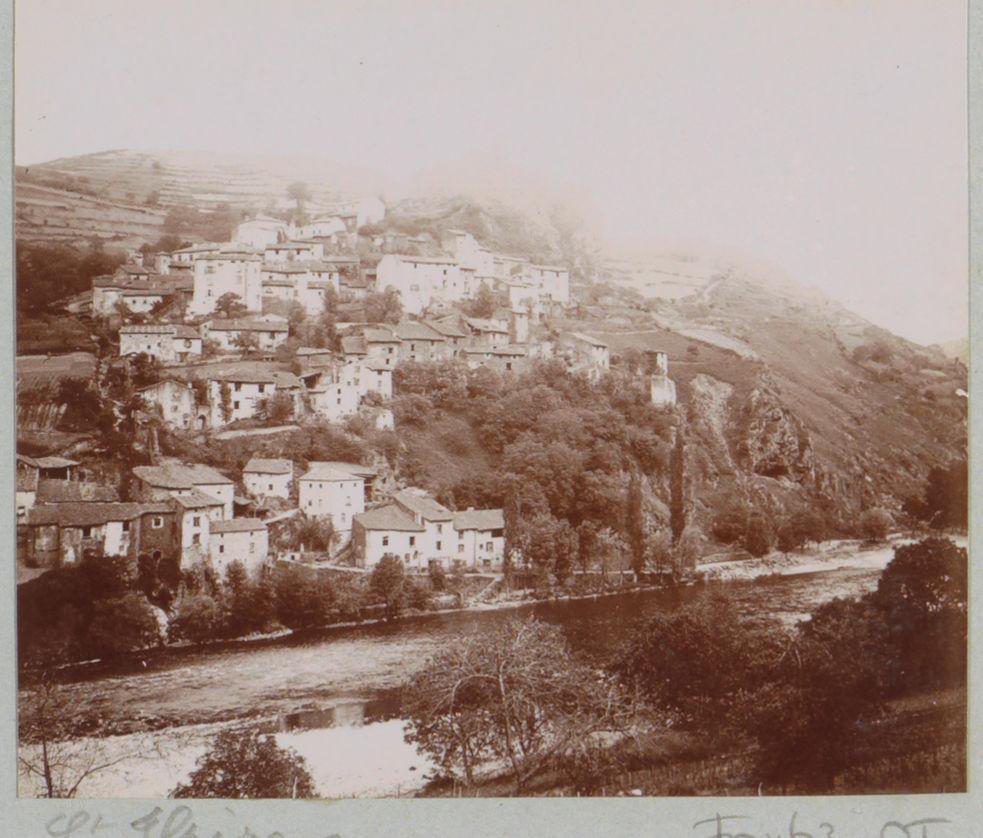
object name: photograph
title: Gezicht op Saint-Ilpize aan de Allier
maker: delizy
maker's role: manufacturer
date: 1902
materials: paper, photographic support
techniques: gelatin silver print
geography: saint-ilpize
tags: prospect of village, silhouette of village, river (+ landscape with figures, staffage)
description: Onderdeel van Fotoalbum van een Franse amateurfotograaf met opnames van uitstapjes in Frankrijk, Spanje, België, Luxemburg en Nederland, de eerste automobielen en autoraces.